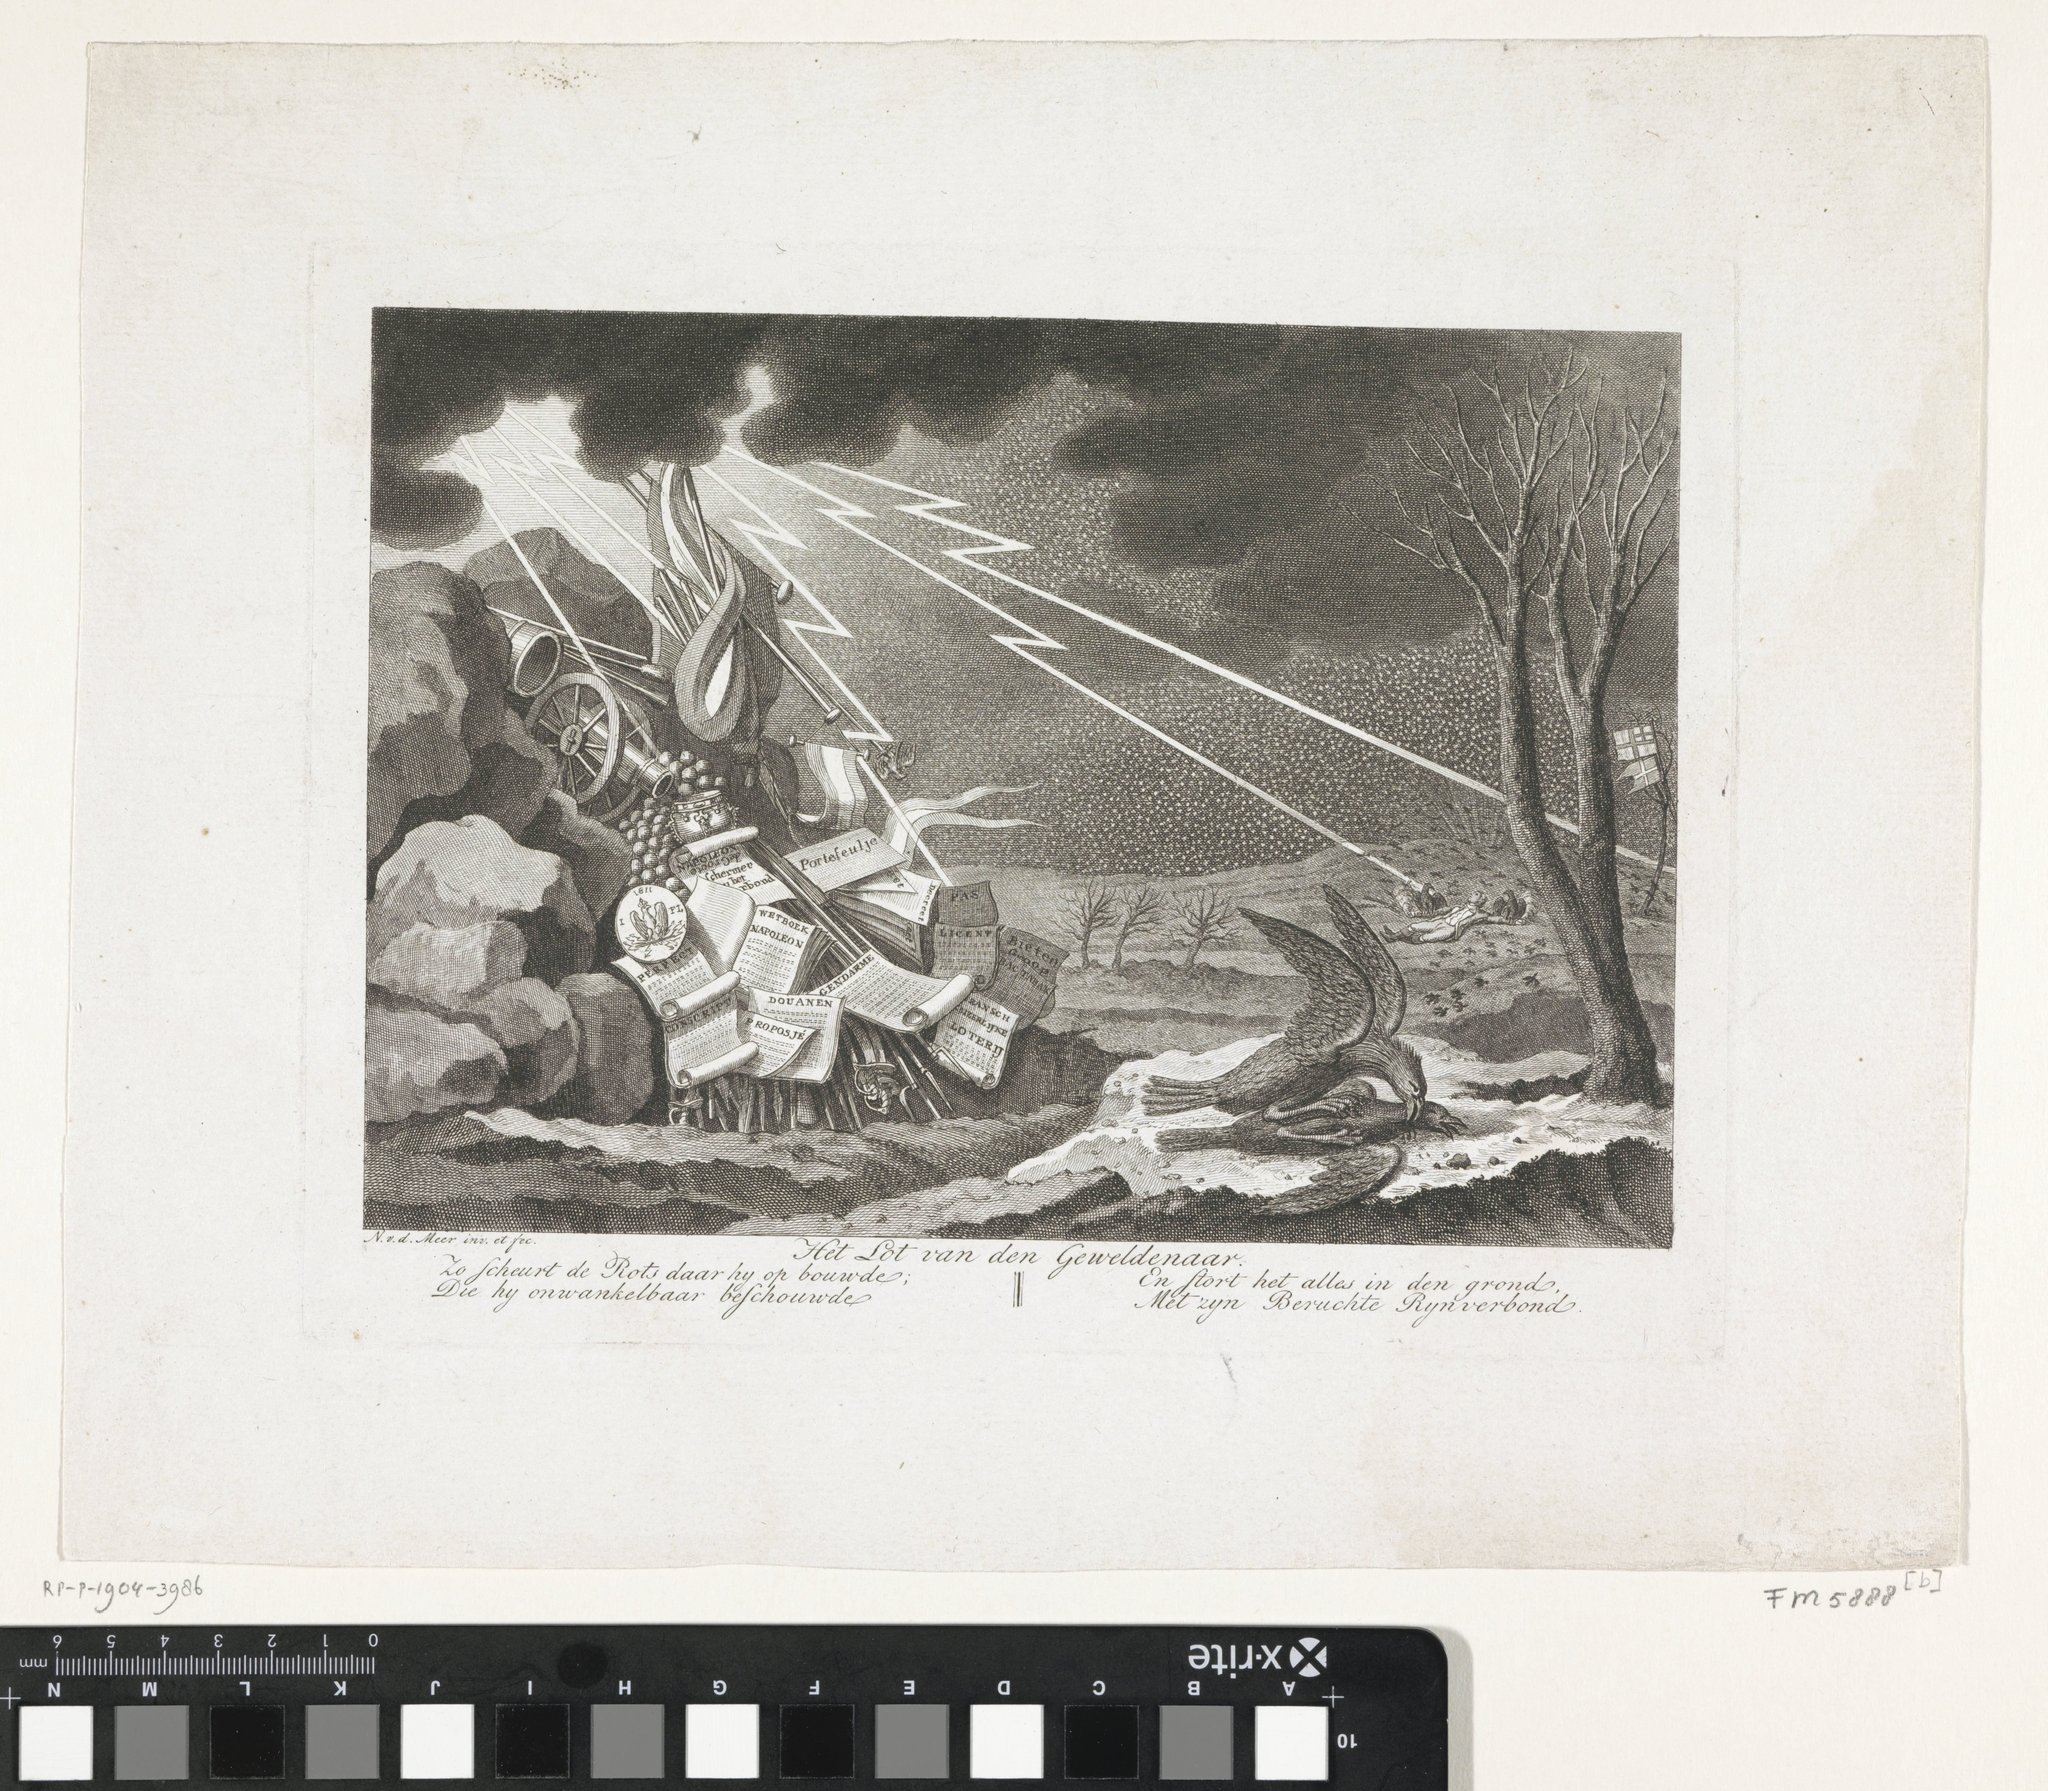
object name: print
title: Allegorie op de val van het Franse bewind, 1813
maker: noach van der meer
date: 1813-1814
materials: paper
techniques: engraving, etching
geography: netherlands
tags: napoleon i (emperor of the french), predatory birds: eagle, weapons, lightning, flash of lightning, thunderbolt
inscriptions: collector's mark: Lugt 2228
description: In een landschap wordt de Franse arend door de Russische arend toegetakeld. Links vallen de Franse wapens, vlaggen en akten in de afgrond. op de achtergrond ligt een Fransman op de grond. Hij wordt door twee arenden bewaakt. Aan de hemel donkere wolken en bliksem. Allegorie op de val van het Napoleontische bewind, 1813. Zie de pendant.